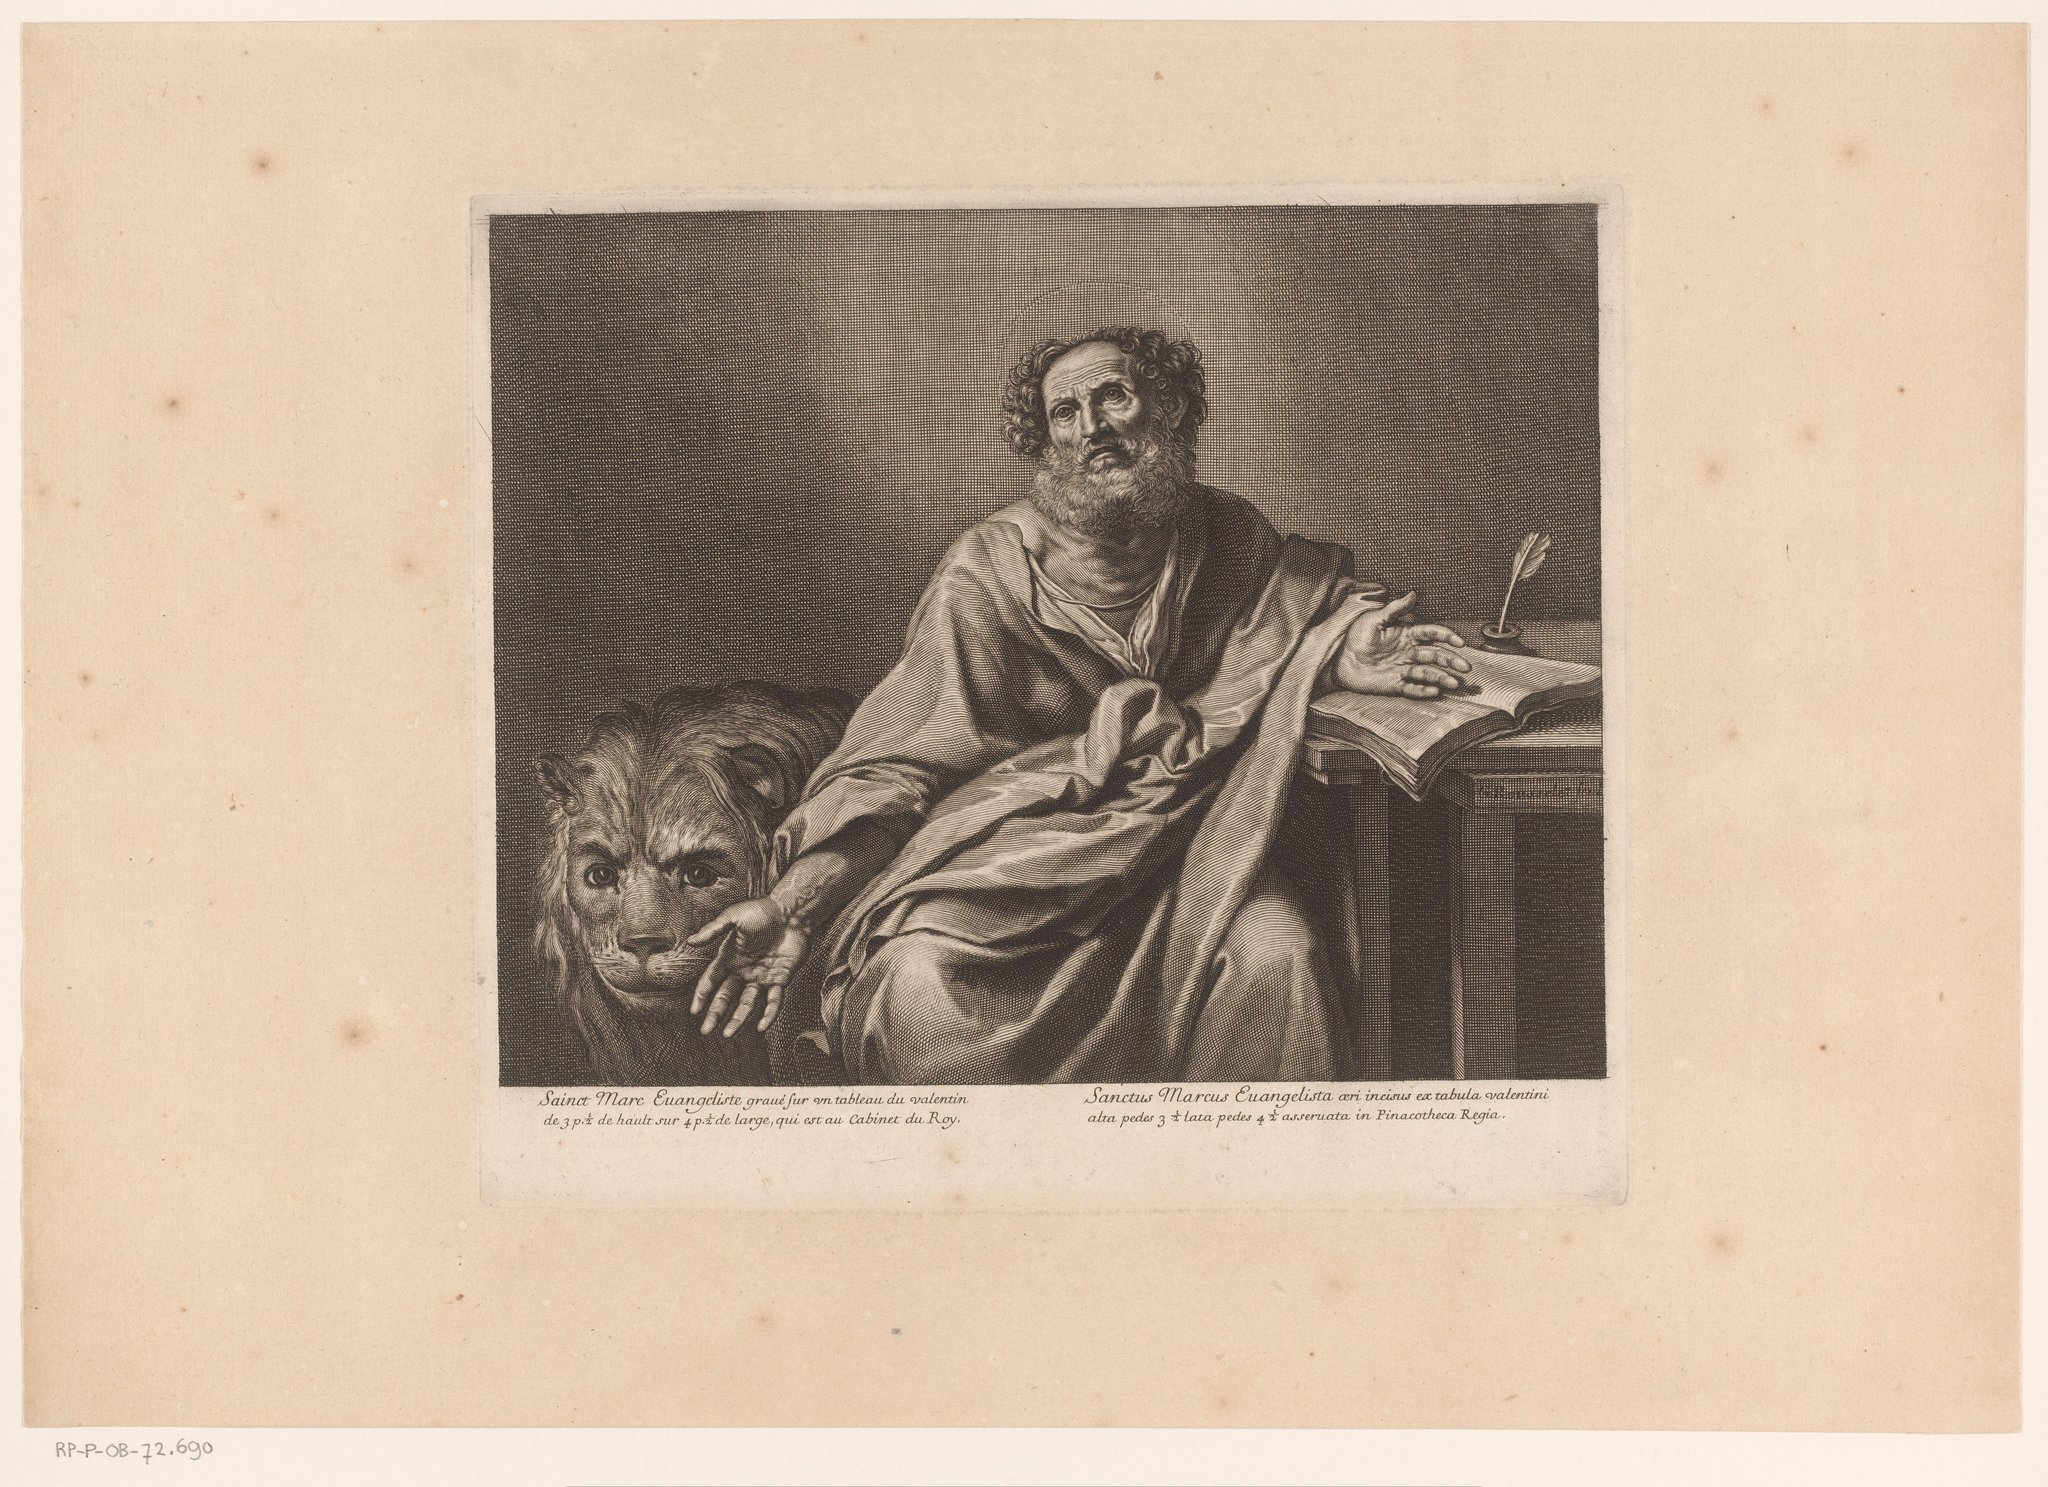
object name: print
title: Vier evangelisten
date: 1671-1672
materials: paper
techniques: engraving, etching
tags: mark (marcus) the evangelist, and bishop of alexandria; possible attributes: book, (winged) lion, pen and inkhorn, scroll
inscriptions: collector's mark: Lugt 2228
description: Prent maakt deel uit van een ongenummerde serie van vier prenten.